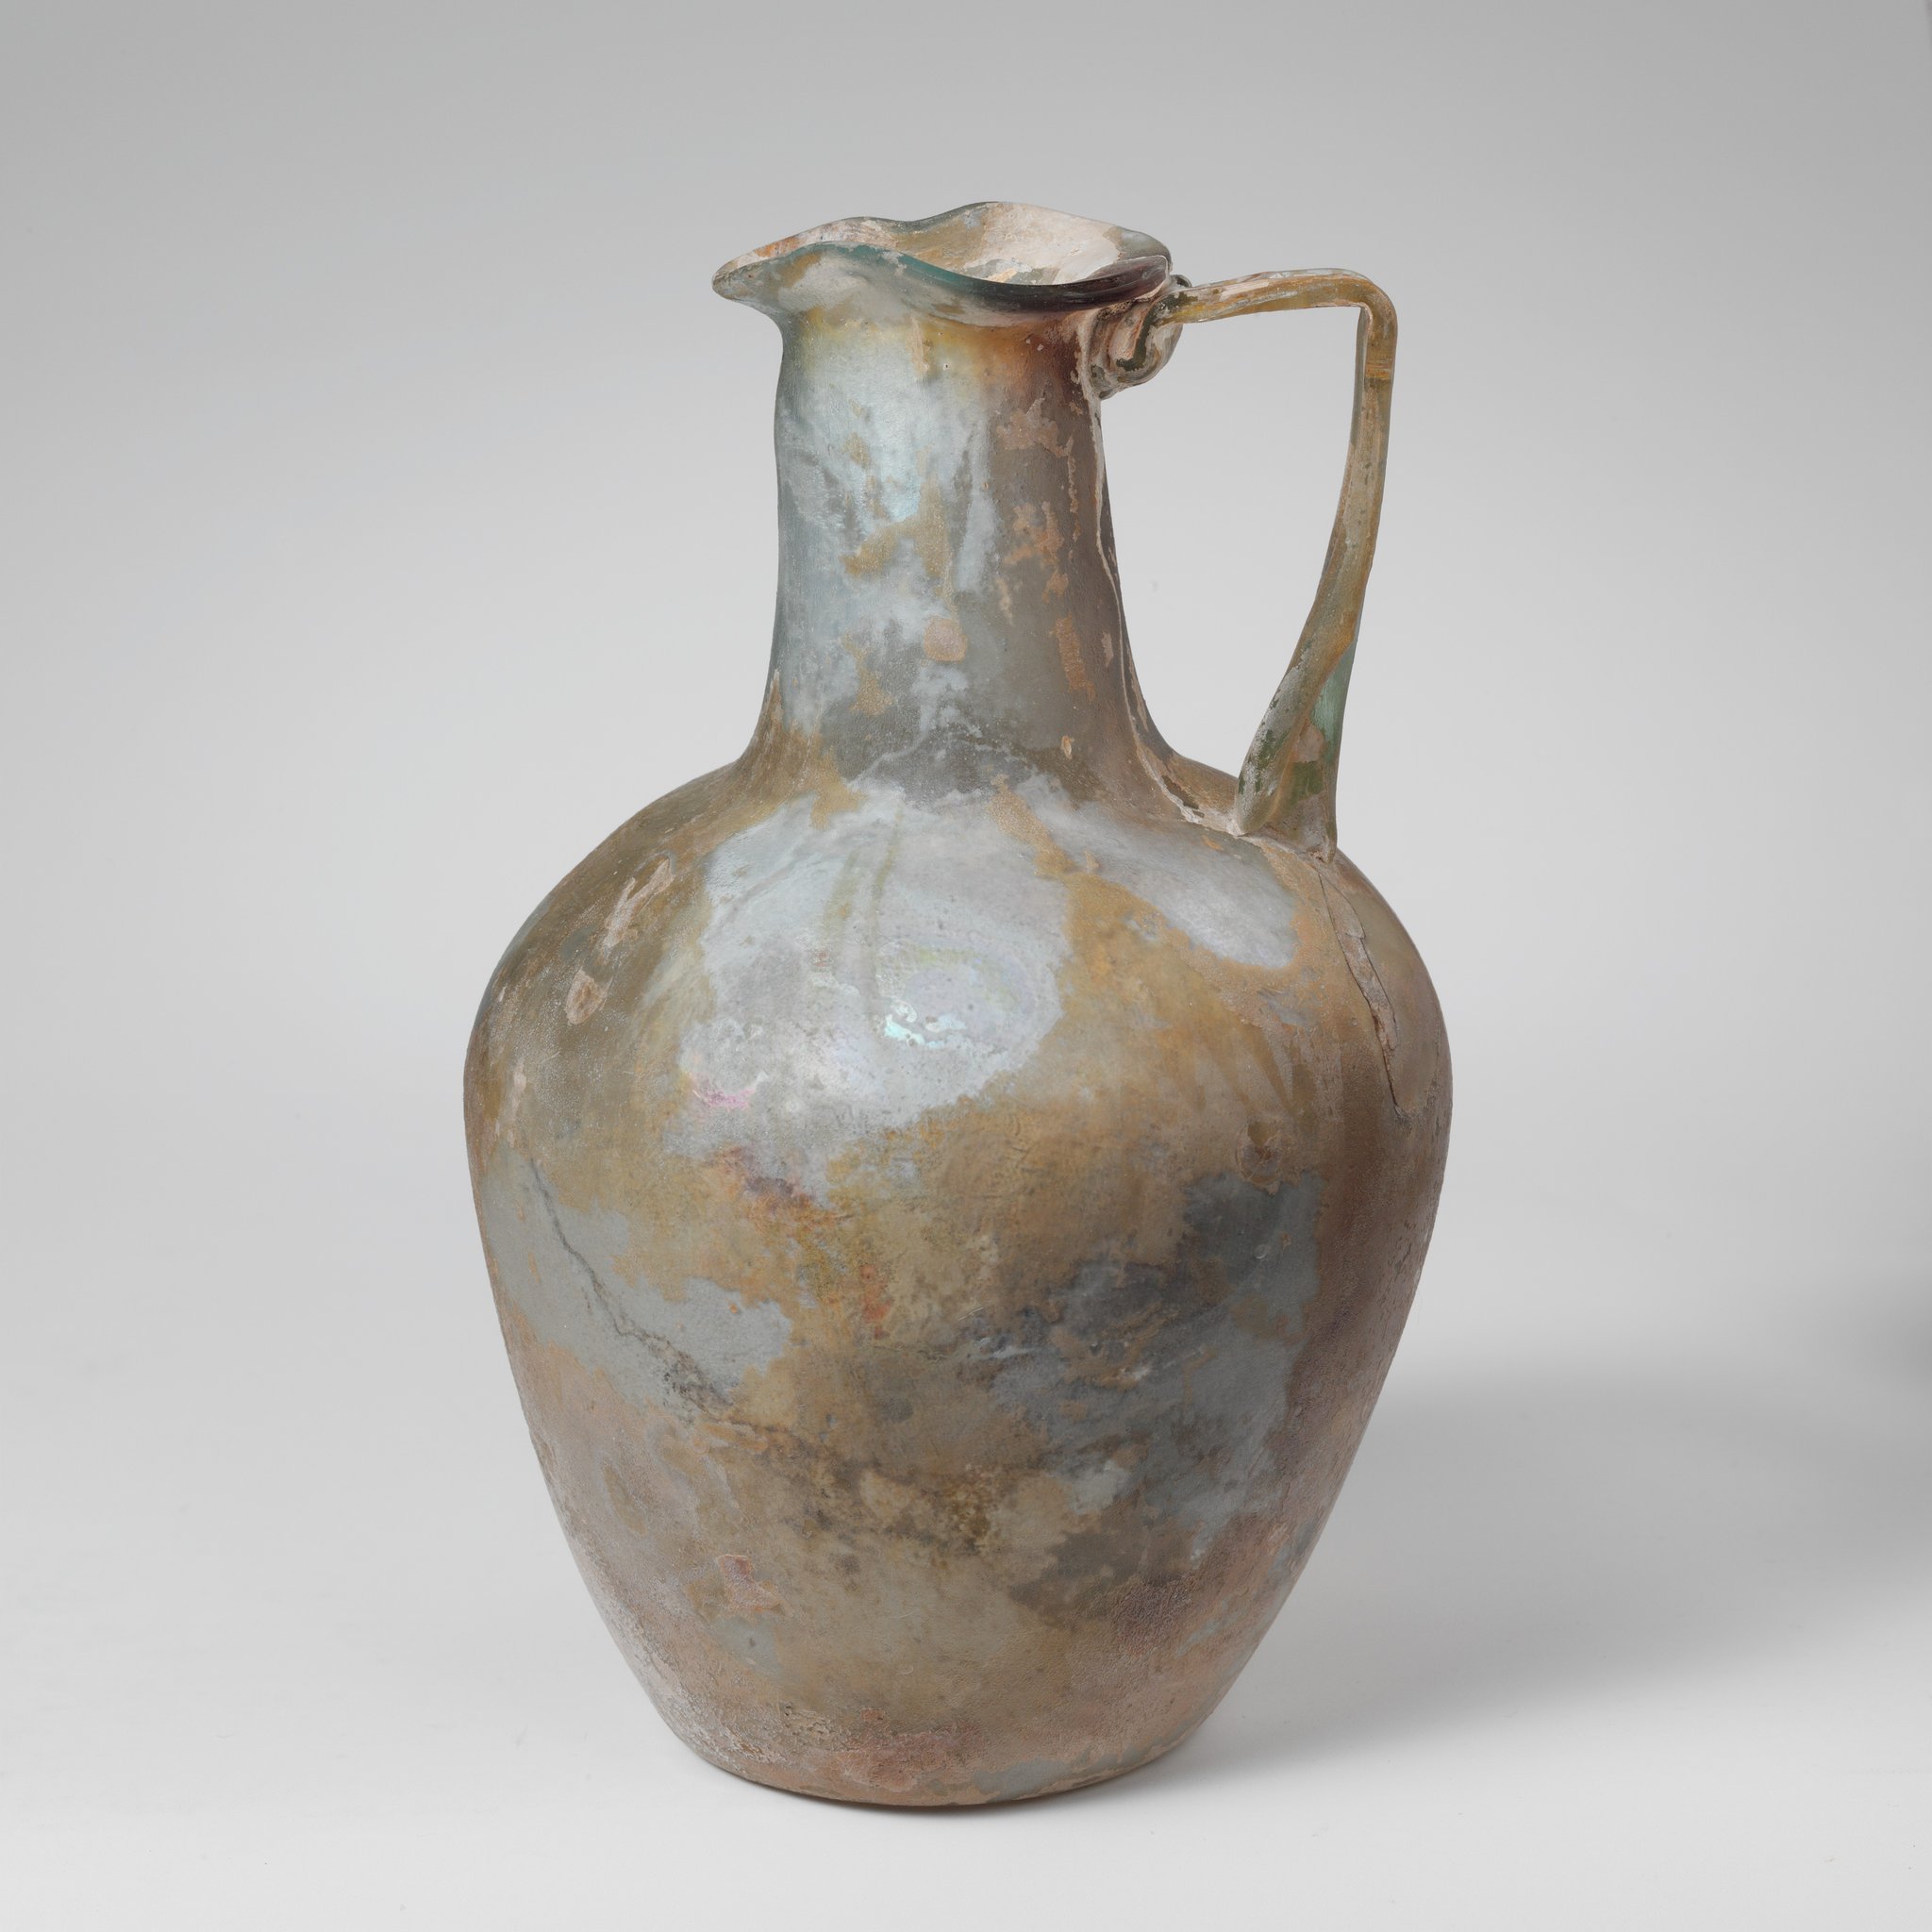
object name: jug with trefoil rim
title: Glass jug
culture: roman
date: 34-200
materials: glass